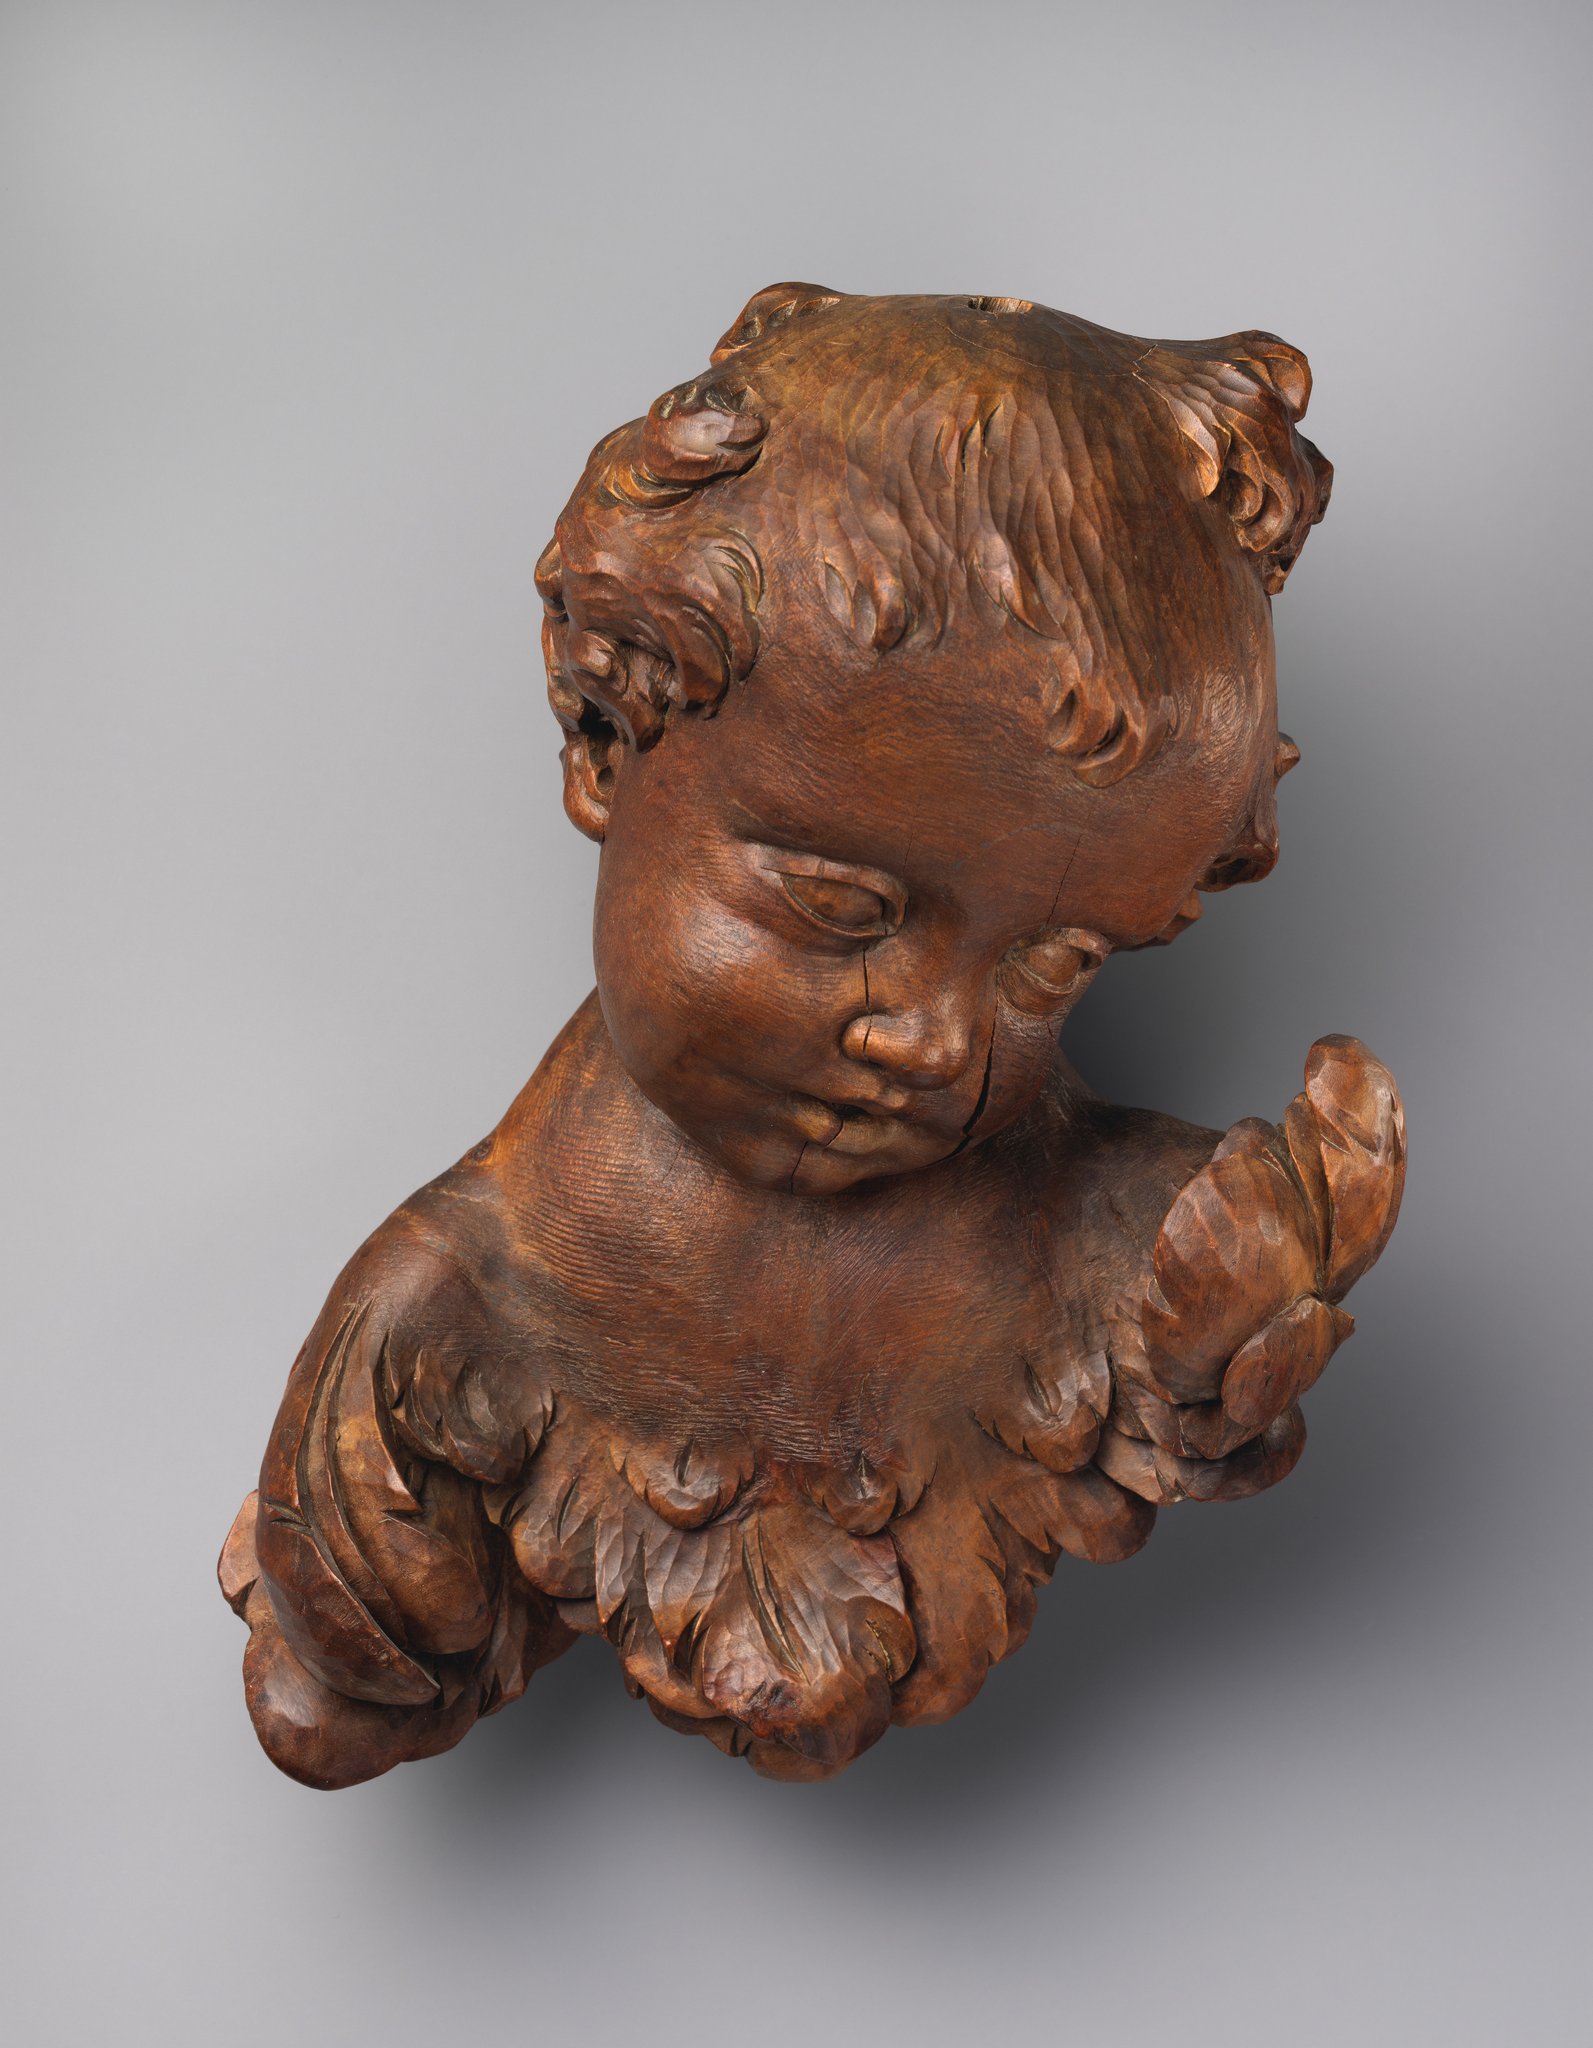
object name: head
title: Angel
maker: ignaz günther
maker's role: artist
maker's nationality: german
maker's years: 1725-1775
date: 1760-1770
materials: gesso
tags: infants